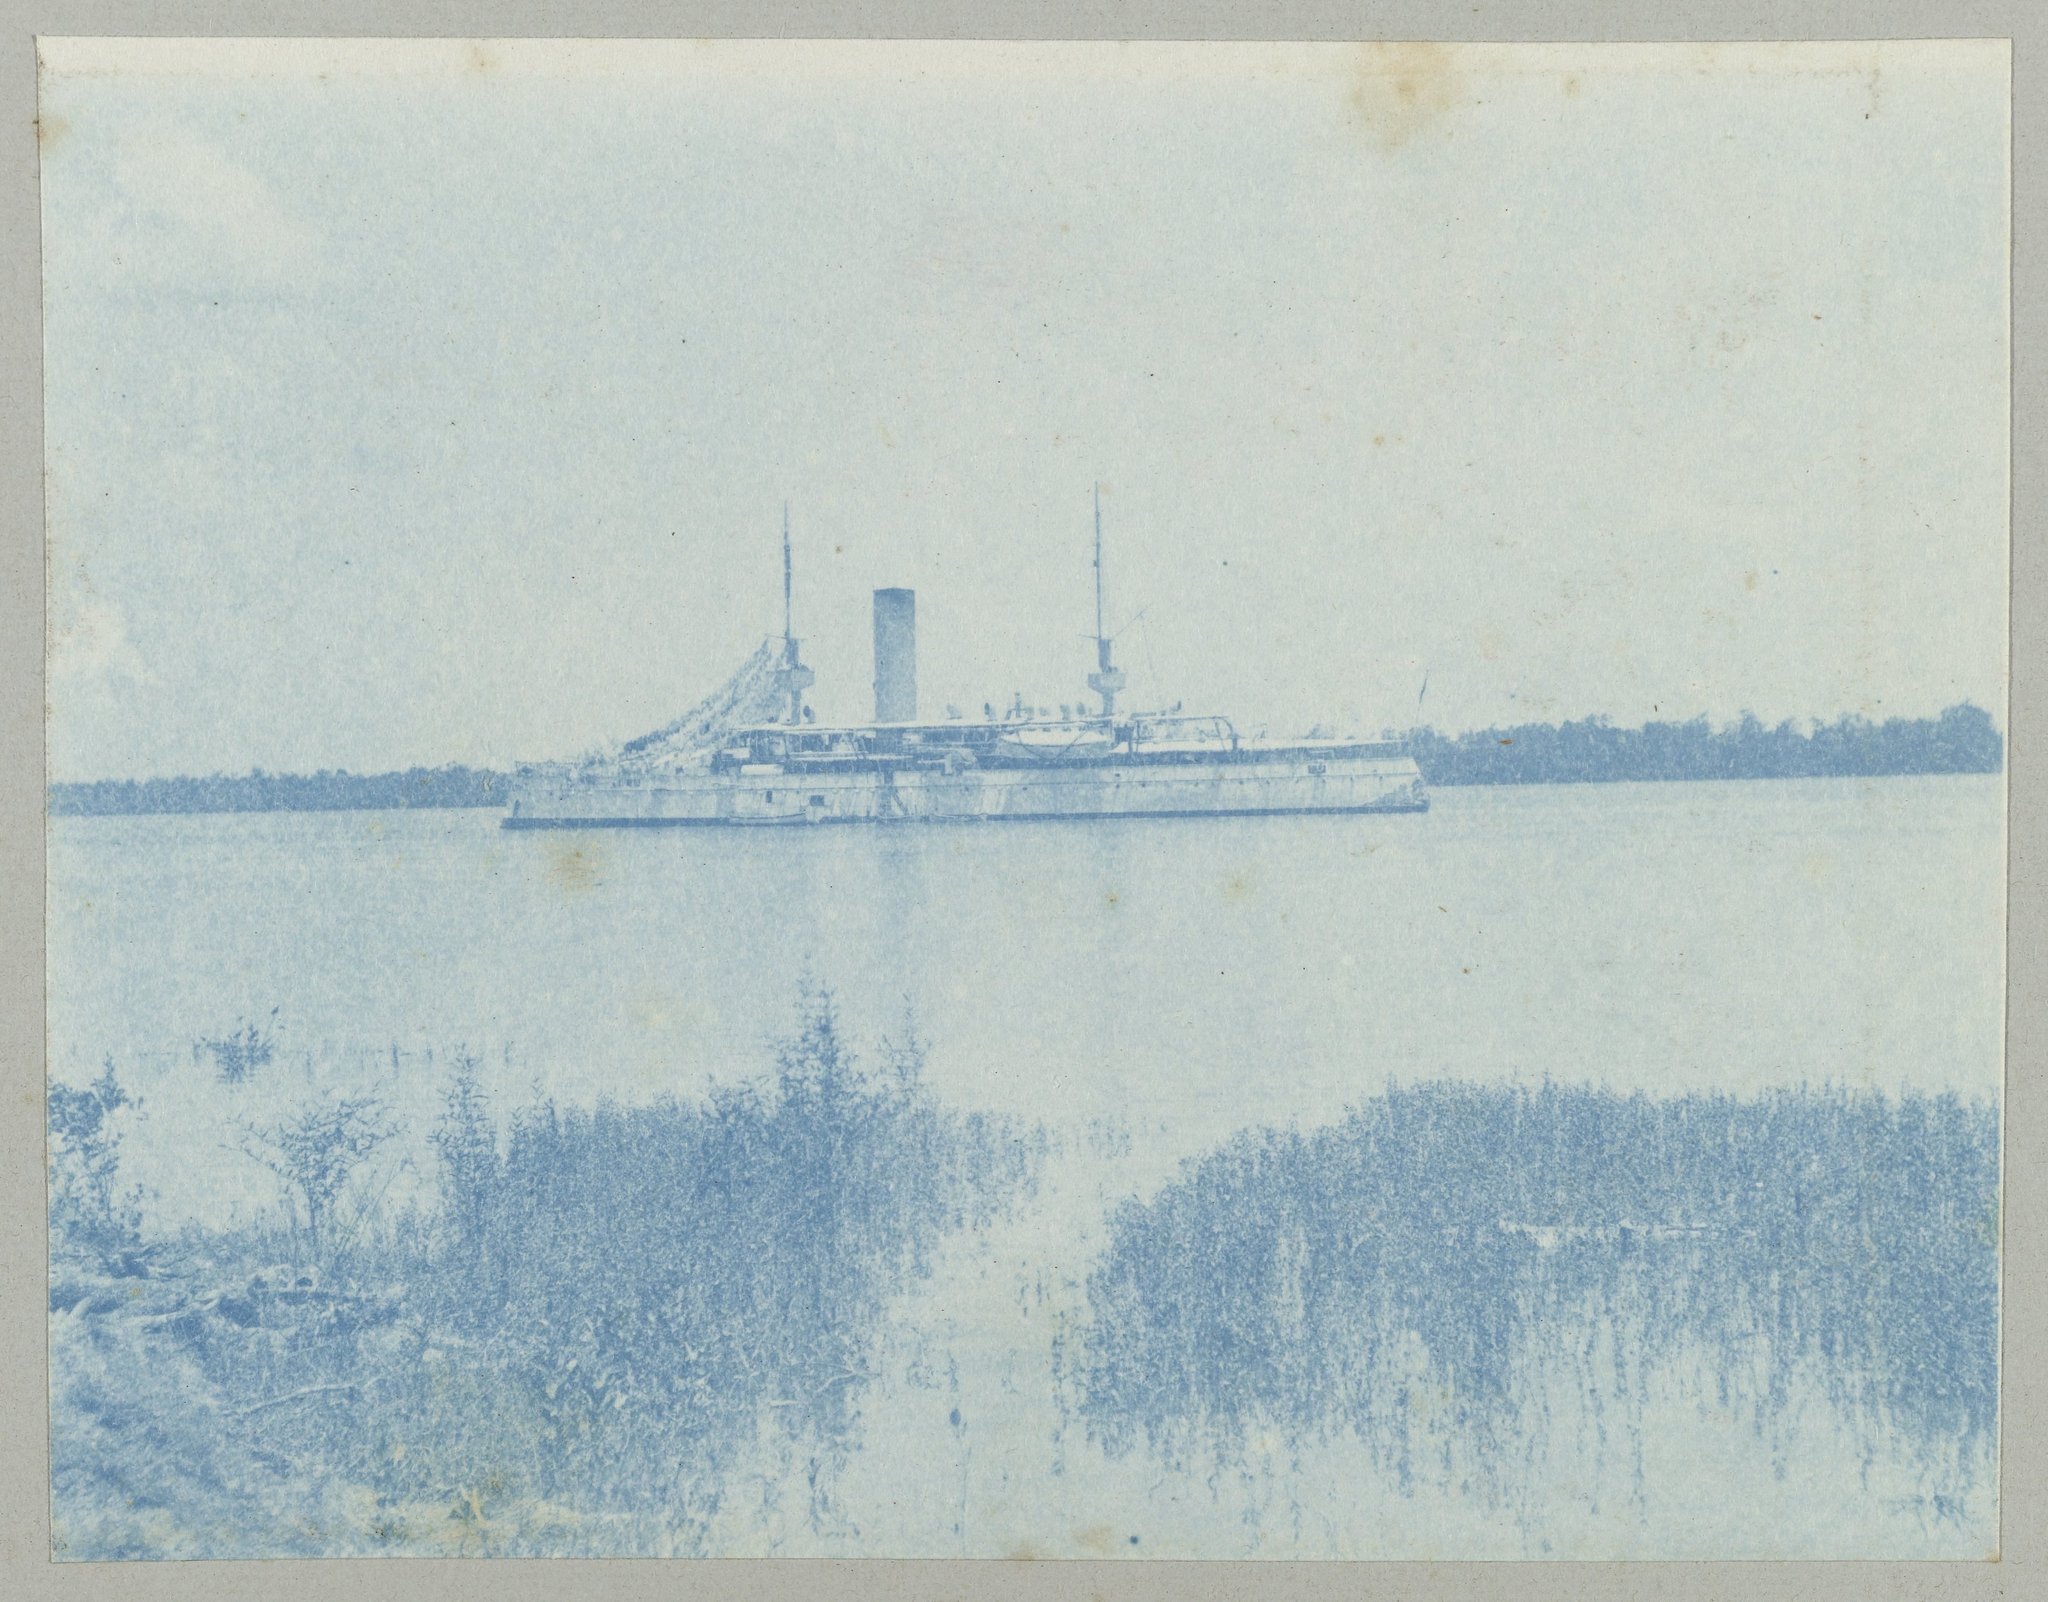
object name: photograph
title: De "Kortenaer" vóór Paramaribo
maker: hendrik doijer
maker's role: engineer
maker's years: 1863-1925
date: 1903-1910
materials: photographic support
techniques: cyanotype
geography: suriname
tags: suriname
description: Het pantserschip de Kortenaer liggend voor de rede van Paramaribo. Onderdeel van het fotoalbum Souvenir de Voyage (deel 1), over het leven van de familie Doijer in en rond de plantage Ma Retraite in Suriname in de jaren 1903-1910.